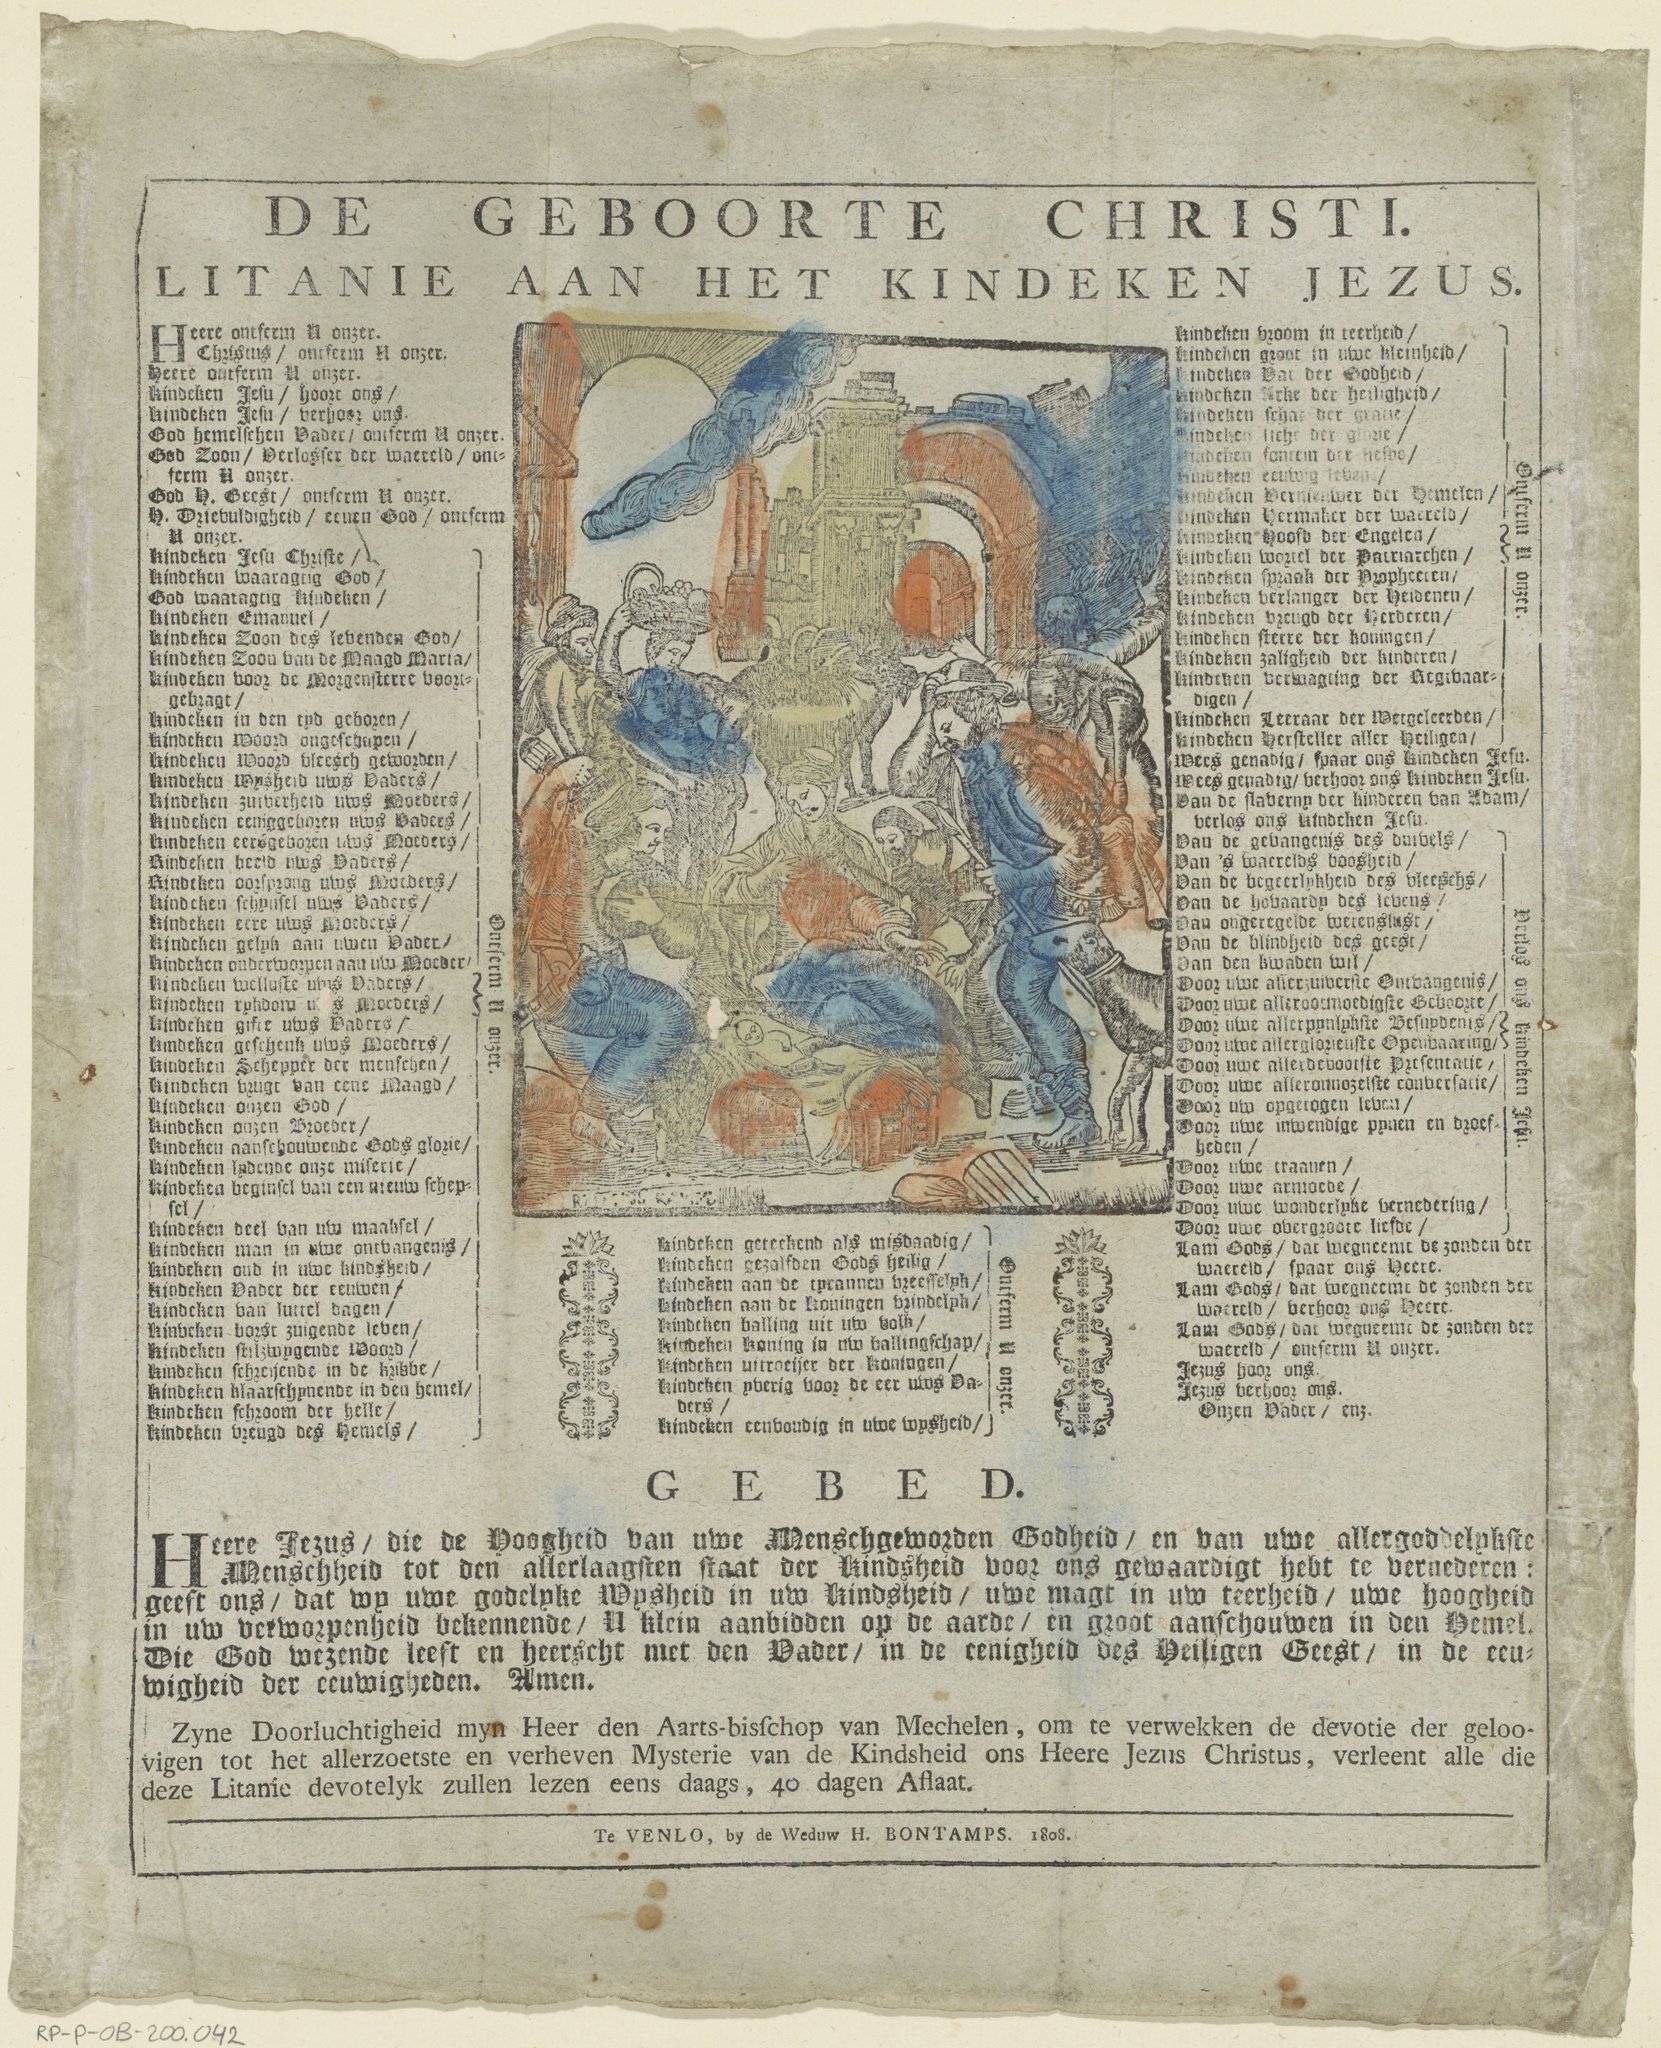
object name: popular print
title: De geboorte Christi. / Litanie aan het kindeken Jezus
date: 1808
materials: paper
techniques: colour, letterpress printing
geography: venlo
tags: adoration of the christ-child by the shepherds; mary and joseph present, ruin of a building ~ architecture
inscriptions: collector's mark: Lugt 2760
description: De aanbidding door de herders. Twee herders staan samen met Maria en Jozef rond de kribbe met het Christuskind. Op de achtergrond antieke ruïnes. Aan weerszijden en onder de voorstelling een gebed in boekdruk.